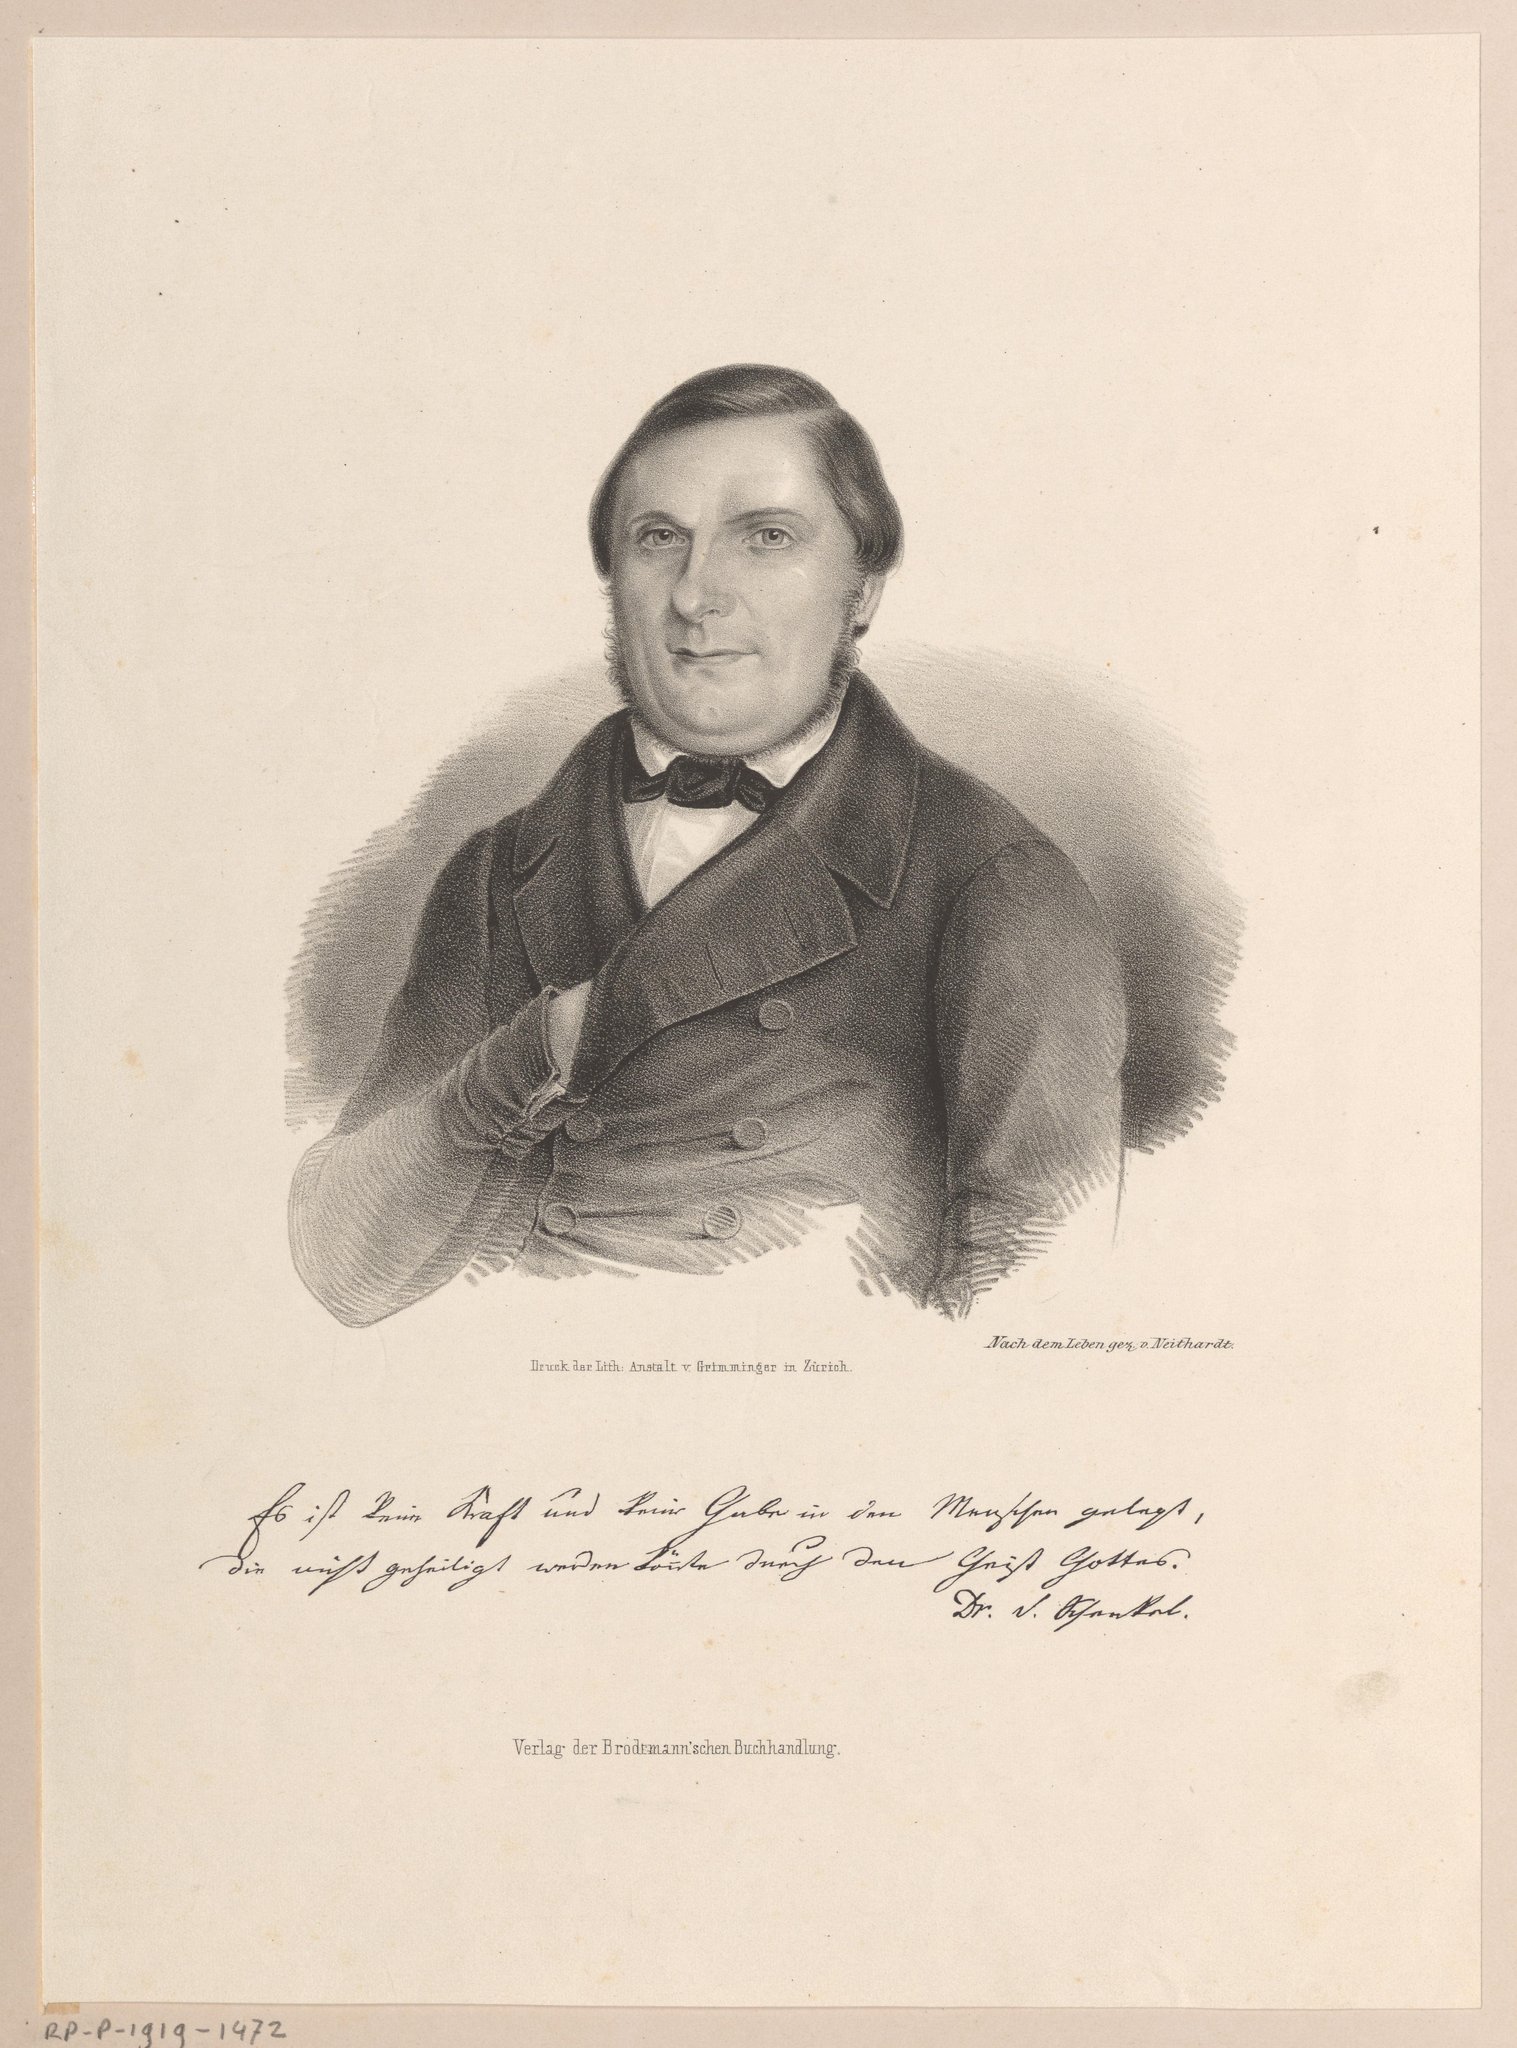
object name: print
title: Portret van Daniel Schenkel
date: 1824-1862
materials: paper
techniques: lithograph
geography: zurich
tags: theologian, historical persons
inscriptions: collector's mark: Lugt 2228